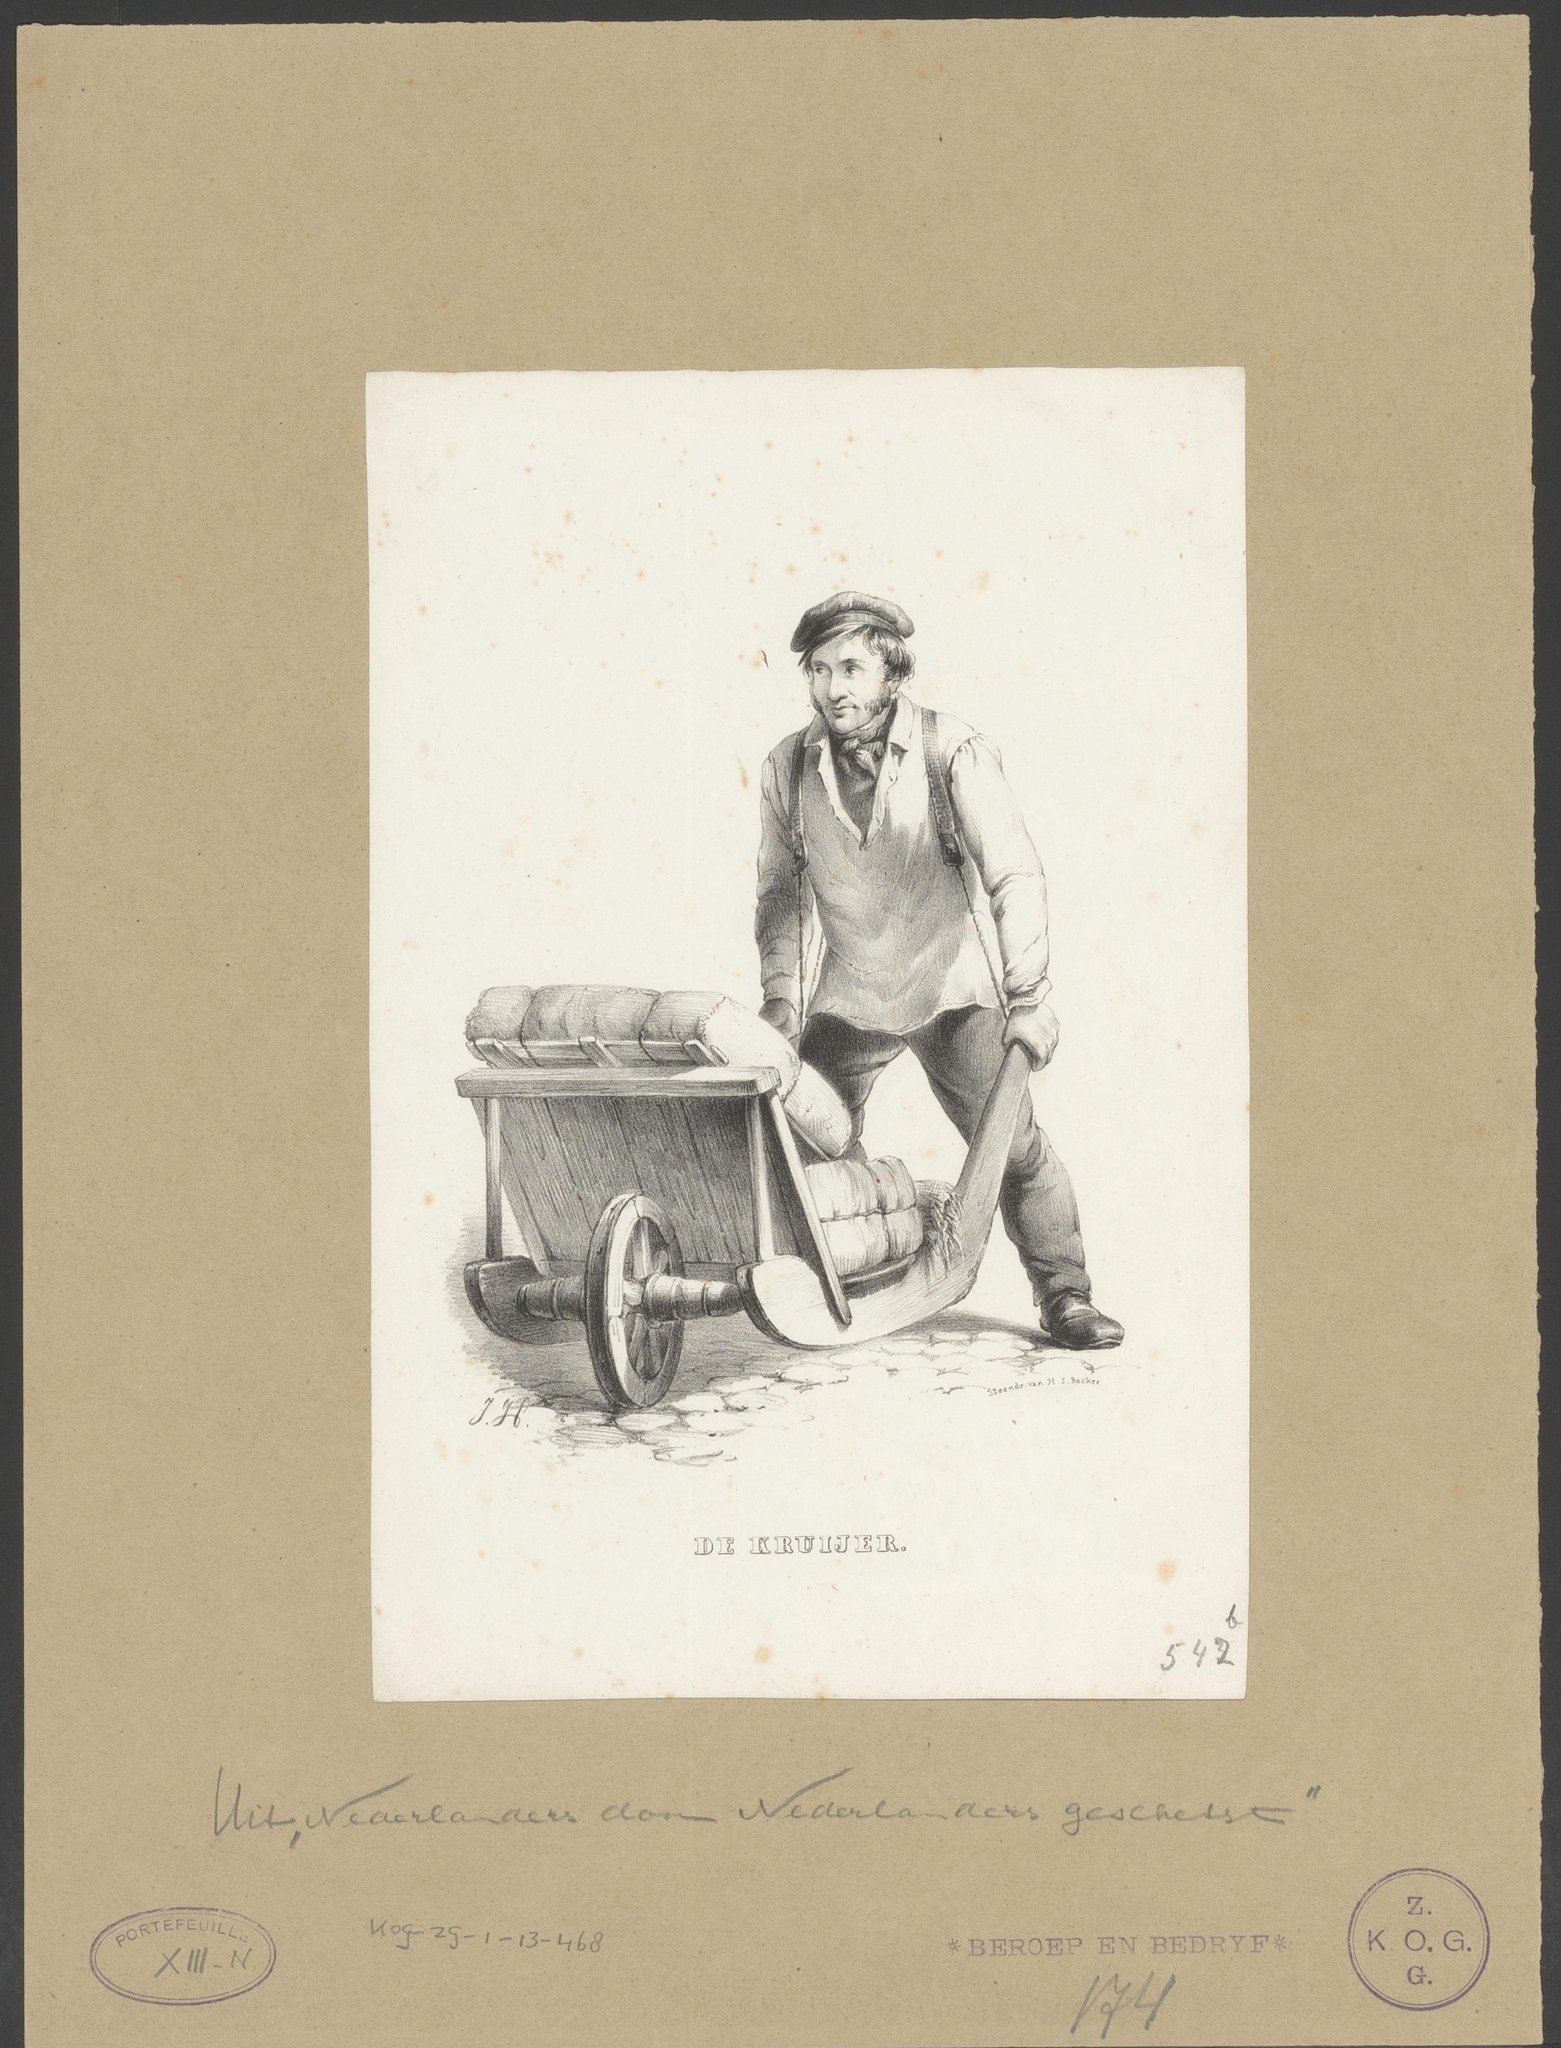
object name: print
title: De kruijer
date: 1842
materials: paper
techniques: lithograph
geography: dordrecht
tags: wheelbarrow, porter, bearer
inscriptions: collector's mark: Lugt 1641, stamp, stamp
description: Onderwerpsrubrieken binnen de Atlas Zeden en Gewoonten: Handel, Nijverheid en verkeer, Beroep en bedrijf, Mannelijk, Kruiers.